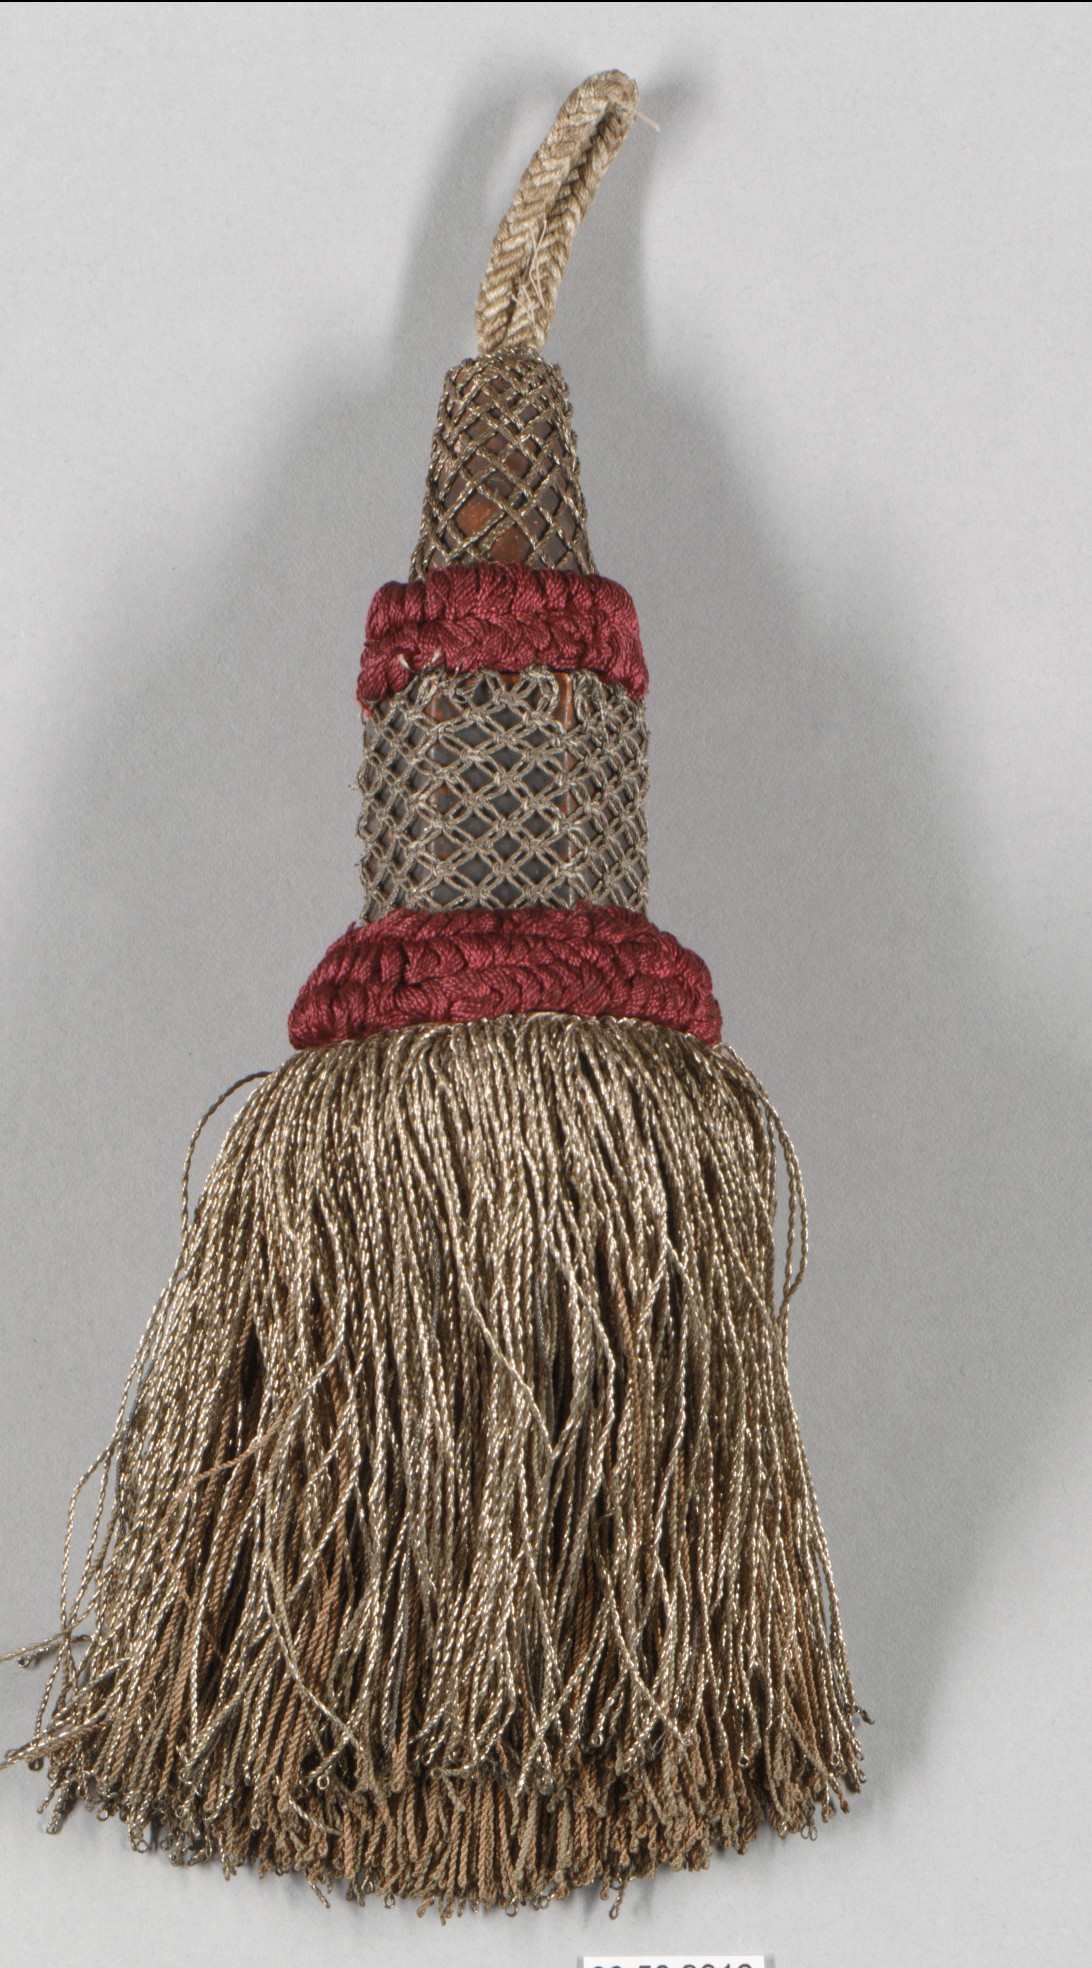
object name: piece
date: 1601-1700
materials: metal thread, silk